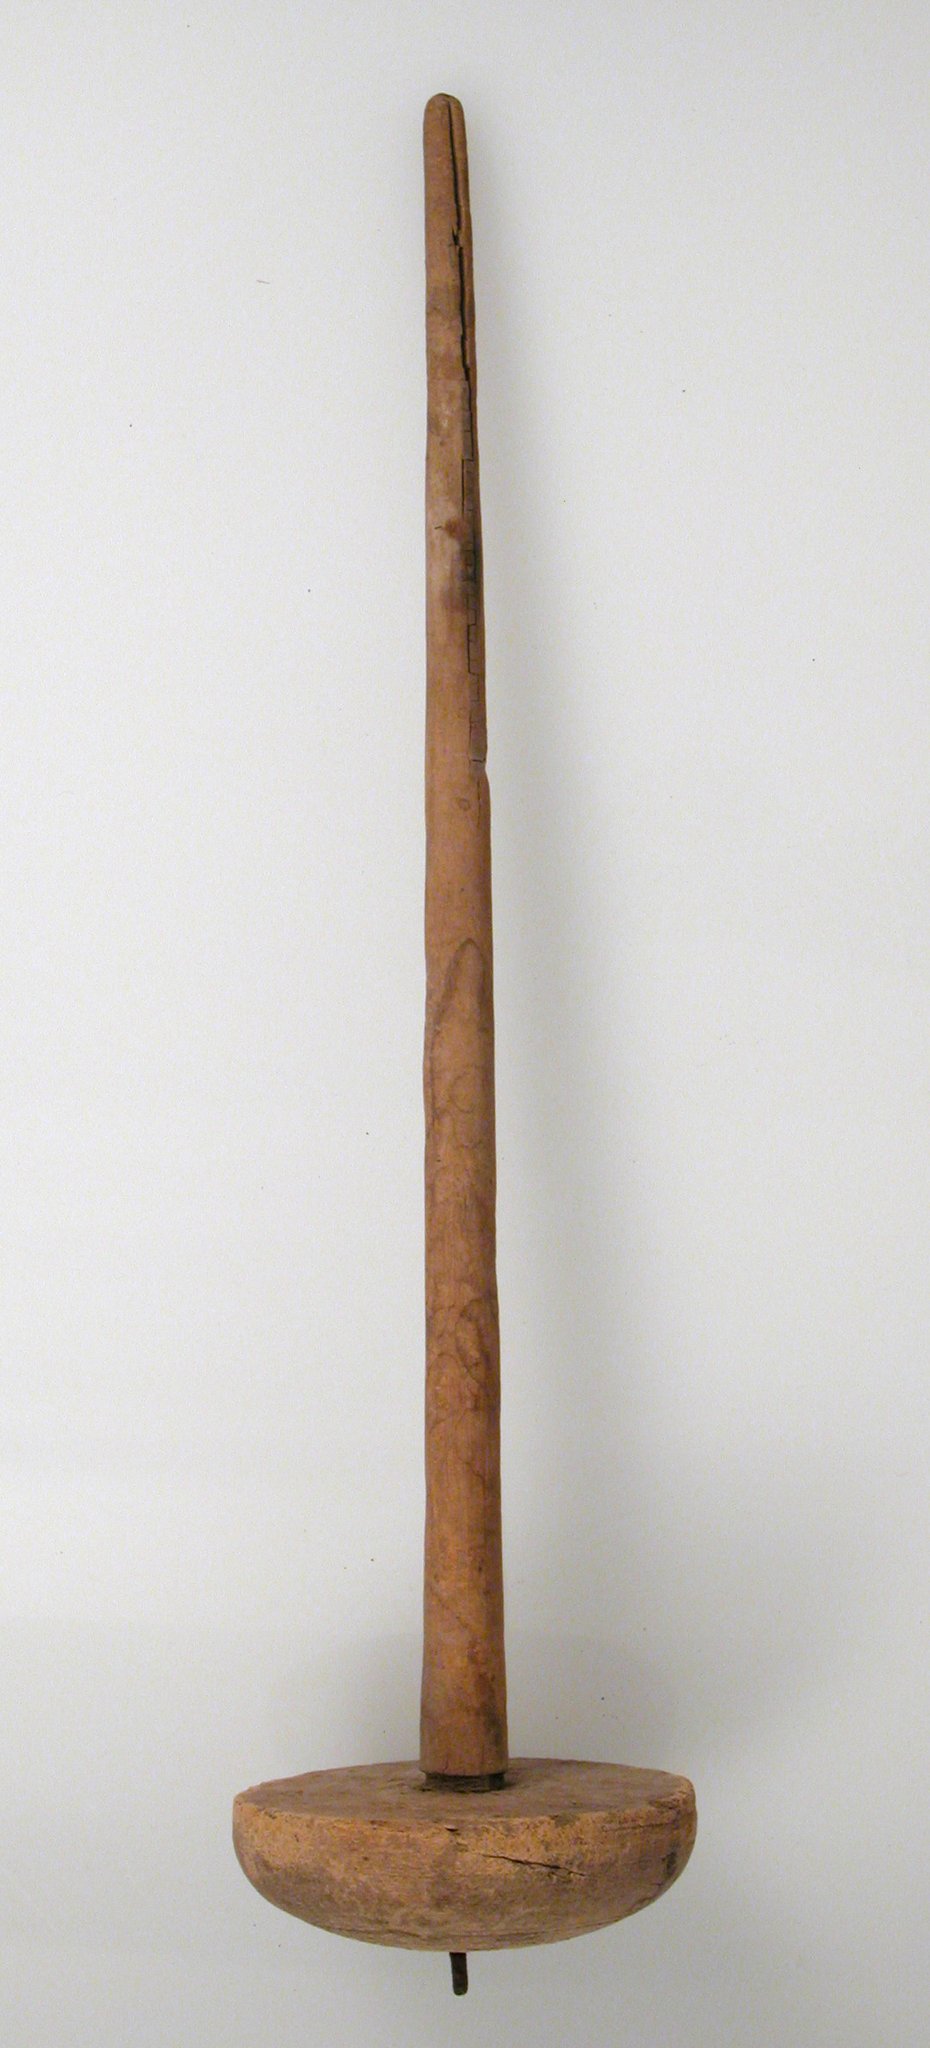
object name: spindle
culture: coptic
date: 580-640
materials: iron, wood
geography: egypt